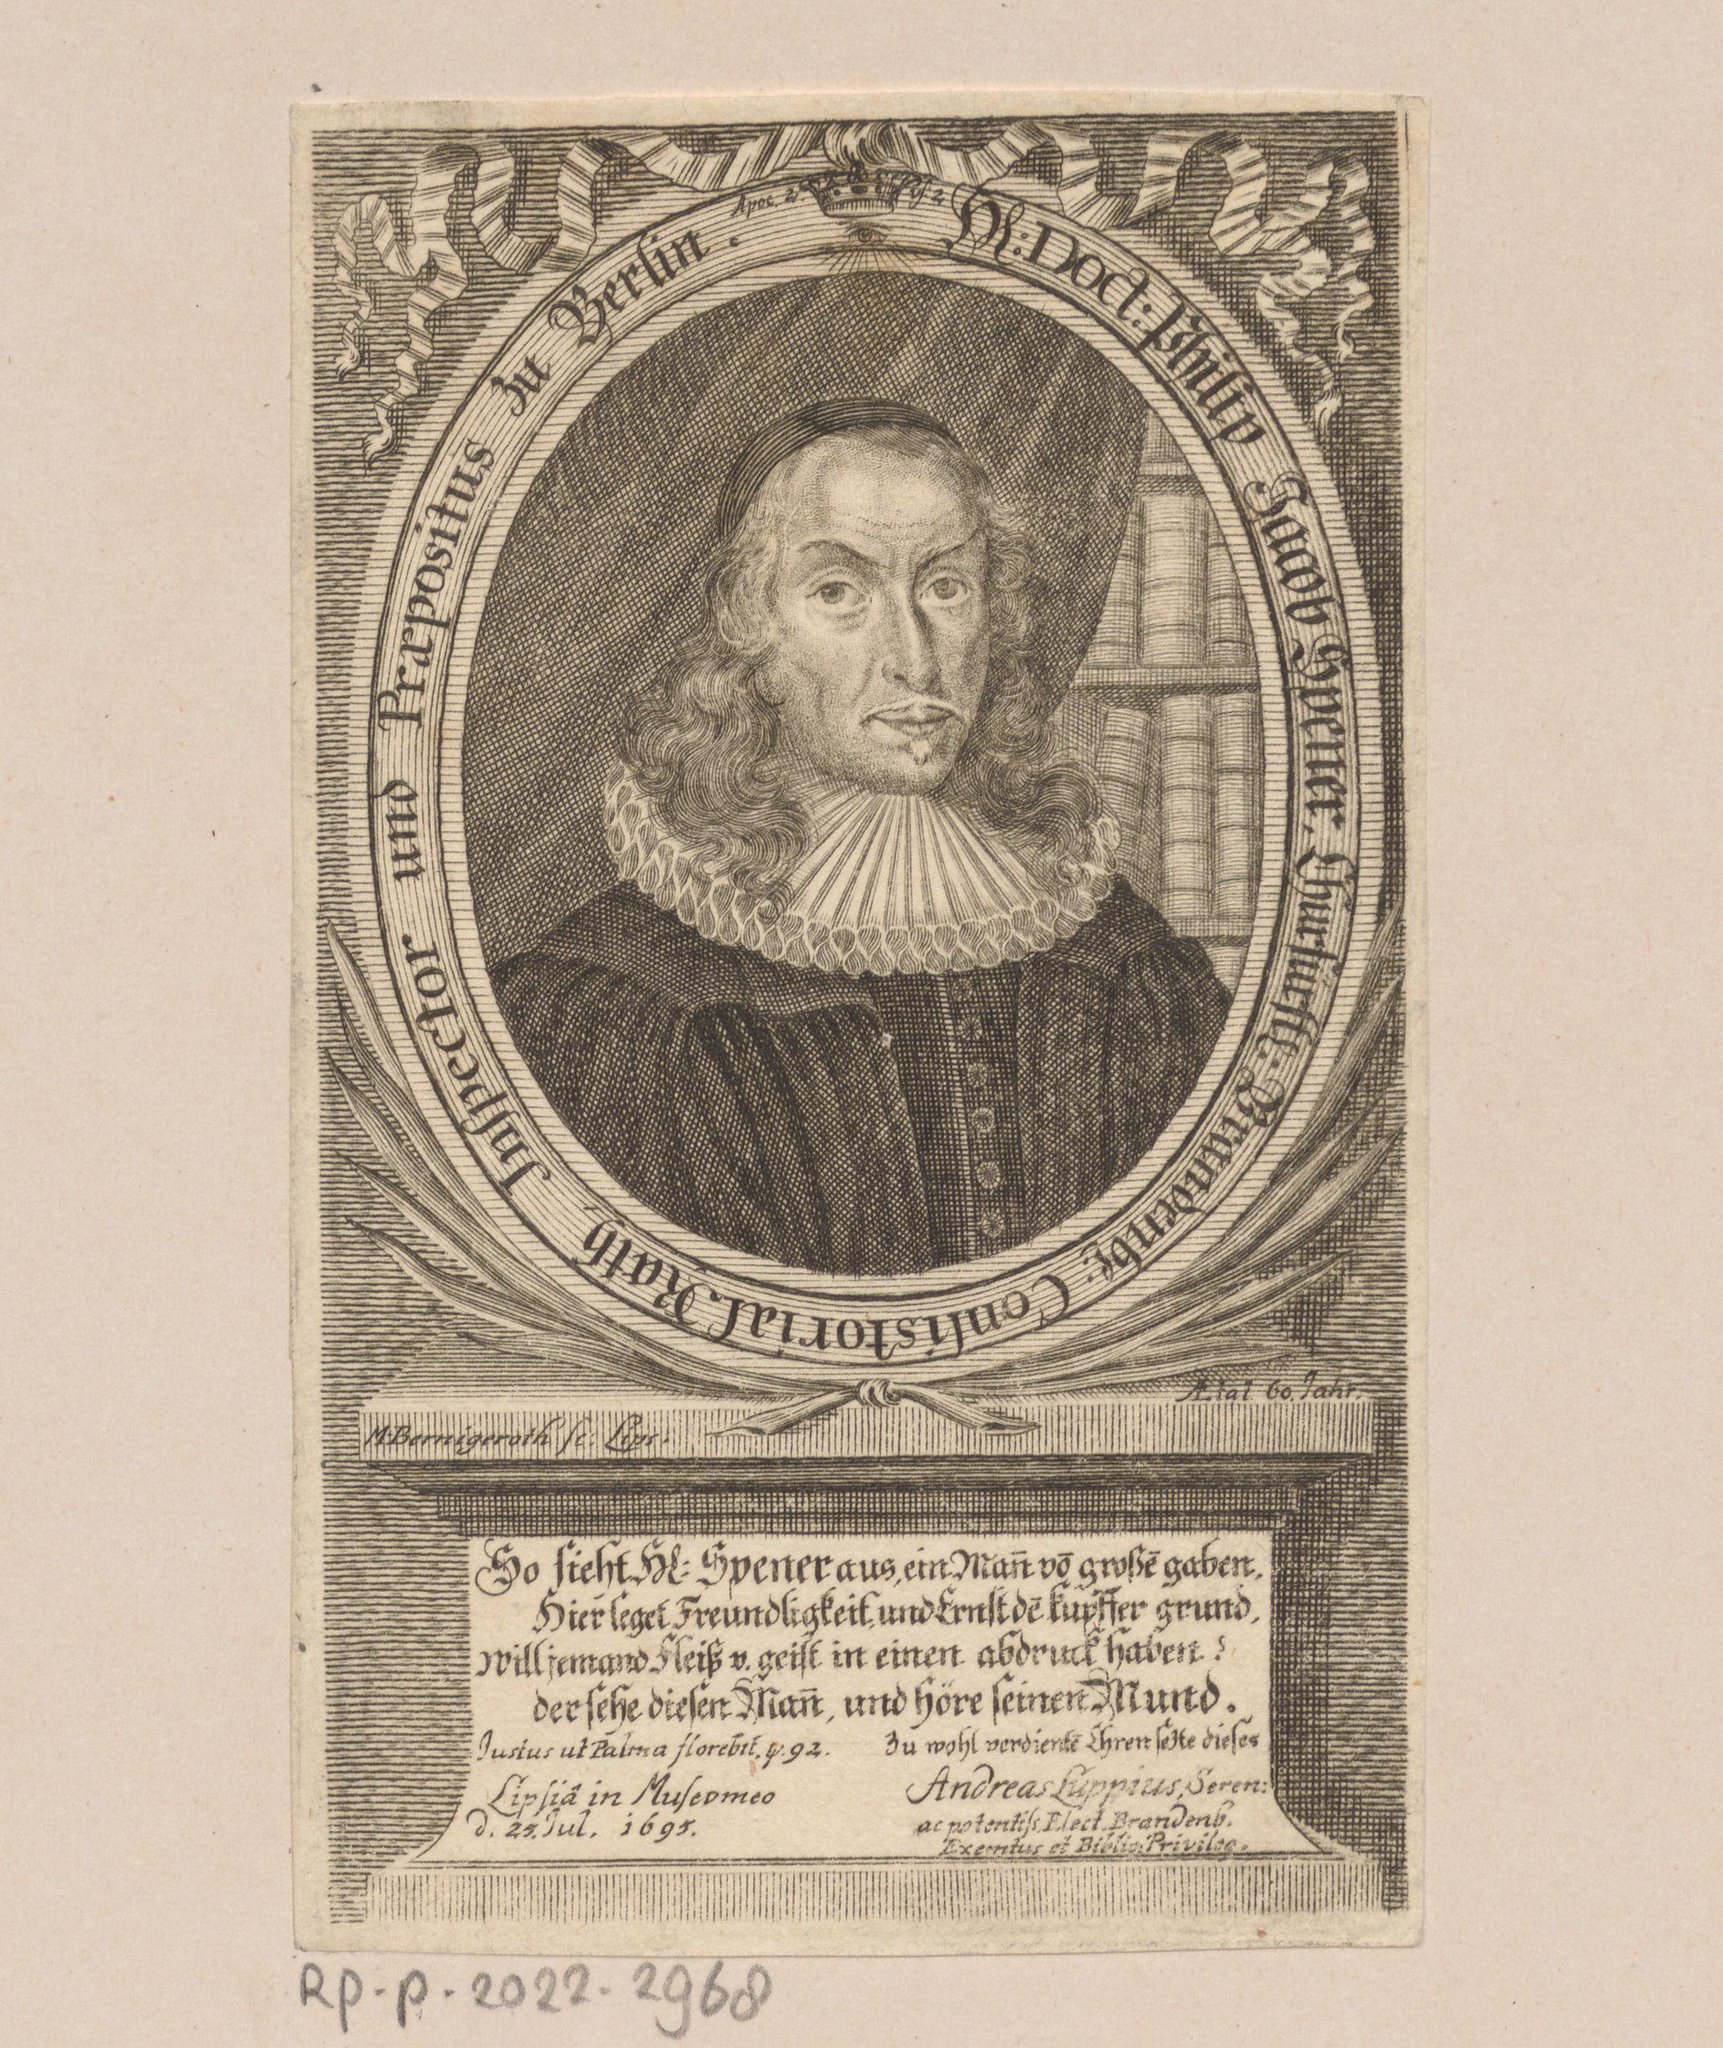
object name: print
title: Portret van Philipp Jacob Spener op 60-jarige leeftijd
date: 1694-1703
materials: paper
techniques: engraving, etching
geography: leipzig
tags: berlin, philipp jacob spener, theologian, historical persons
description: Met vierregelig onderschrift in het Duits en tekst in het Duits rondom het portret.